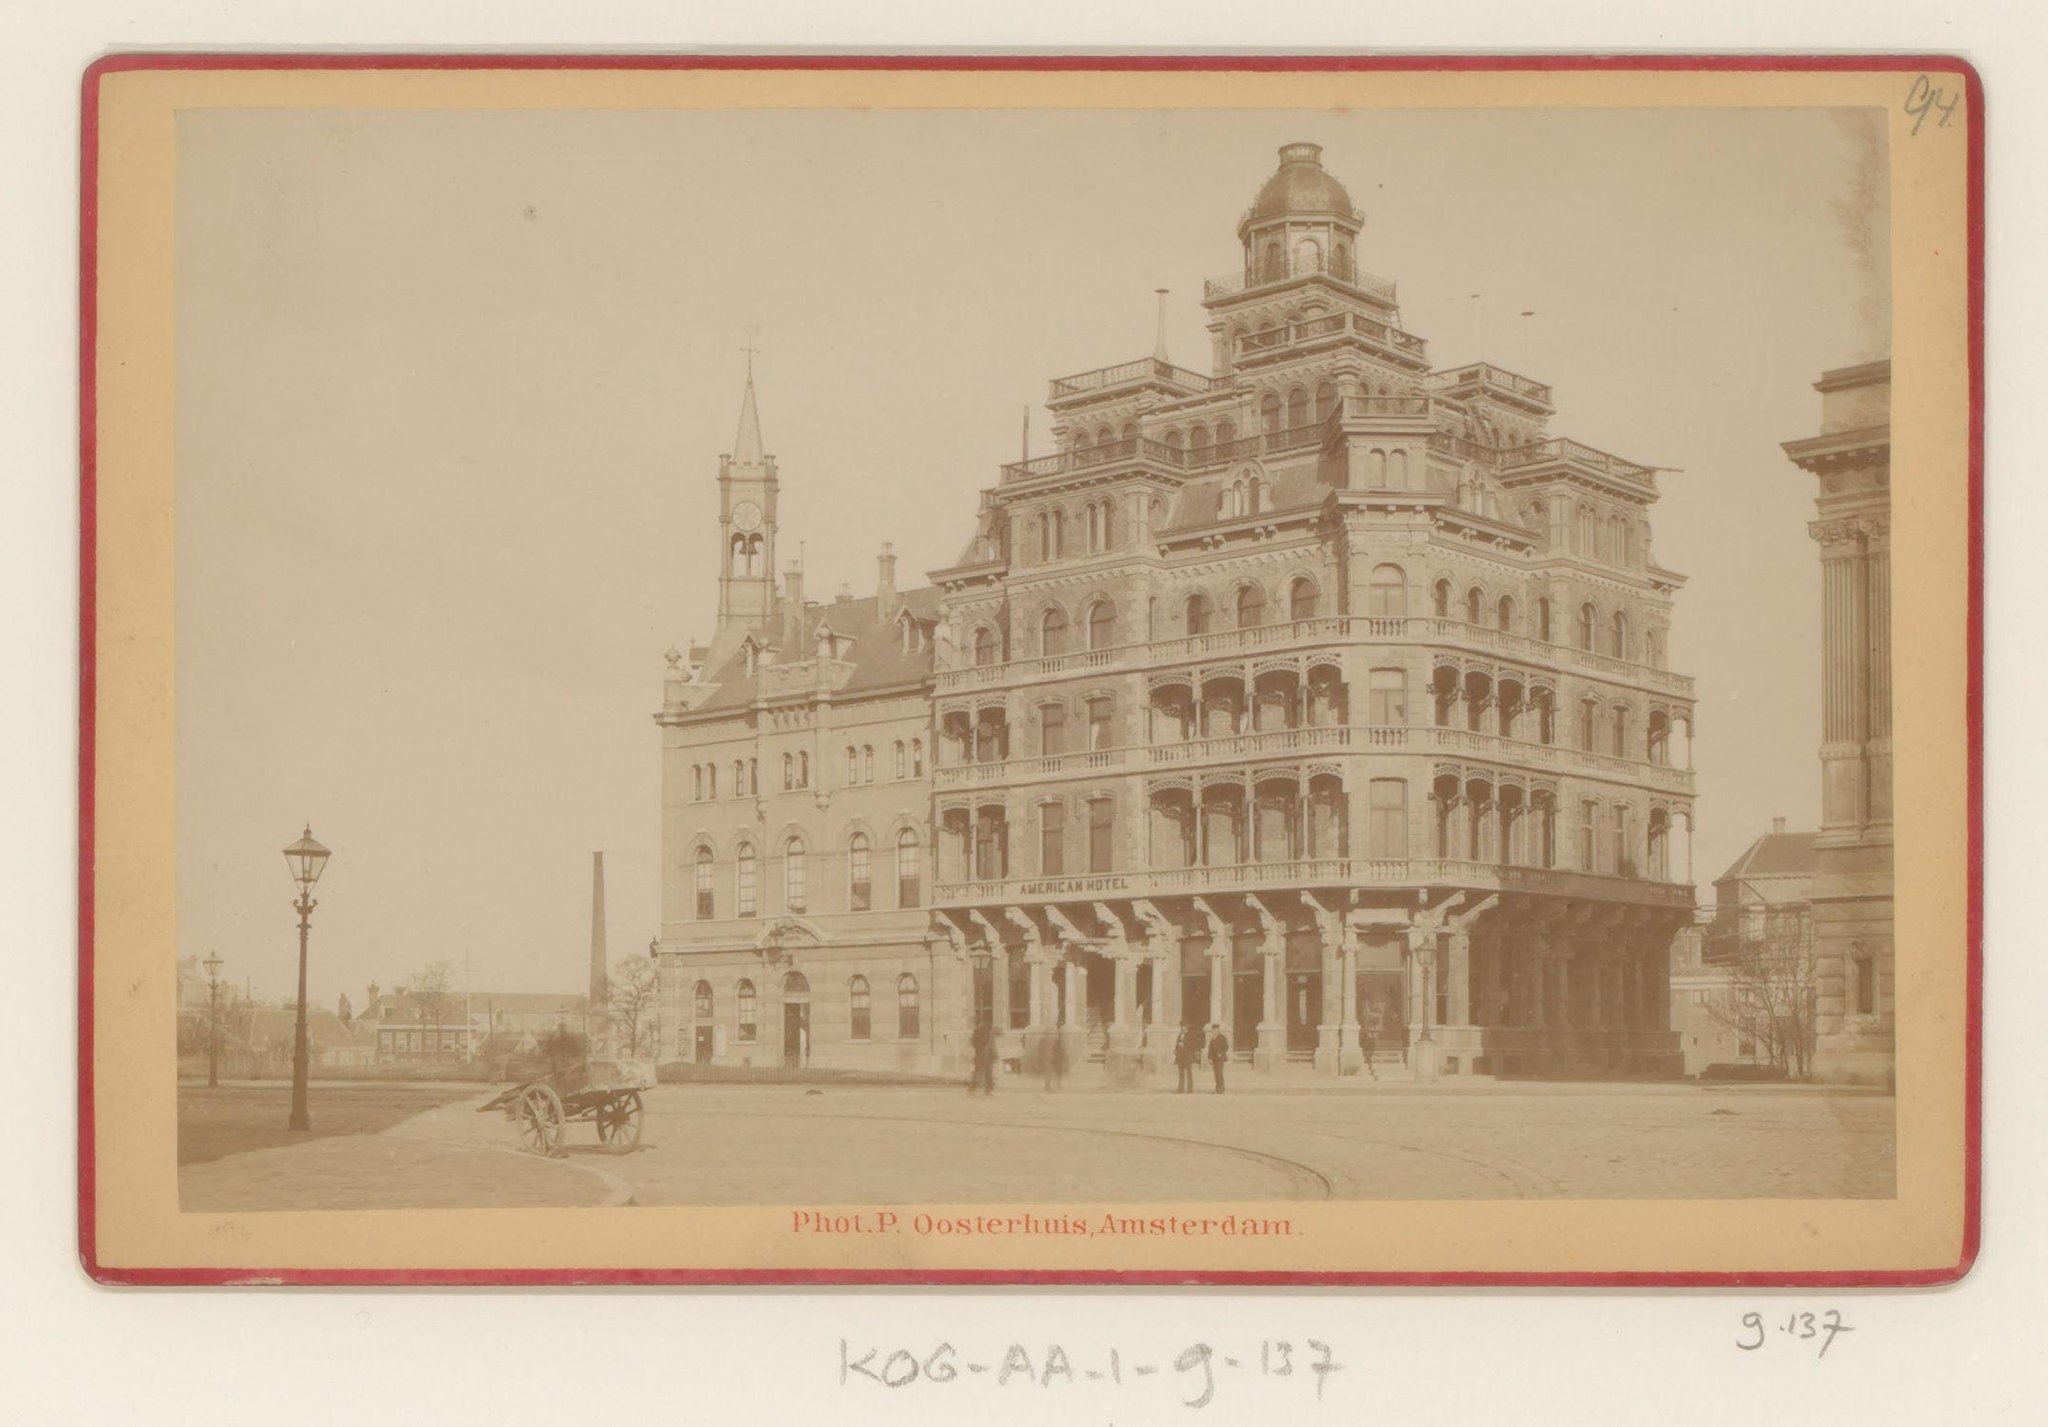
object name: cabinet photograph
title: Gezicht op het Leidseplein met het Amstel Hotel en het politiebureau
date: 1881-1885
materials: cardboard, paper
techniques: albumen print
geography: amsterdam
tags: square, place, circus, etc., city-view in general; 'veduta', hôtel, i.e. small palace in city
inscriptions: collector's mark: ‘9.136’ Lugt 1641b, inscription: ‘Leidscheplein / met / Ams Hotel / & / Politie’, : ‘Boekhandel van / G.H.L. Winkelhagen / 7. Raamsteeg 7 Amsterdam’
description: Onderwerpsrubriek binnen de Atlas Amsterdam: 2e Laurierdwarsstraat (Vuile Weespad), Leidschegracht, Leidschekade, Leidscheplein, Leidschestraat, v. Lennepkade, Lijnbaansgracht, Lauriergracht, Leliedwarsstraat, Leliegracht, Lindengracht, Lombardsteeg, Looiersgracht, Looiersstraat (Nieuwe), Leidekkerssteeg.